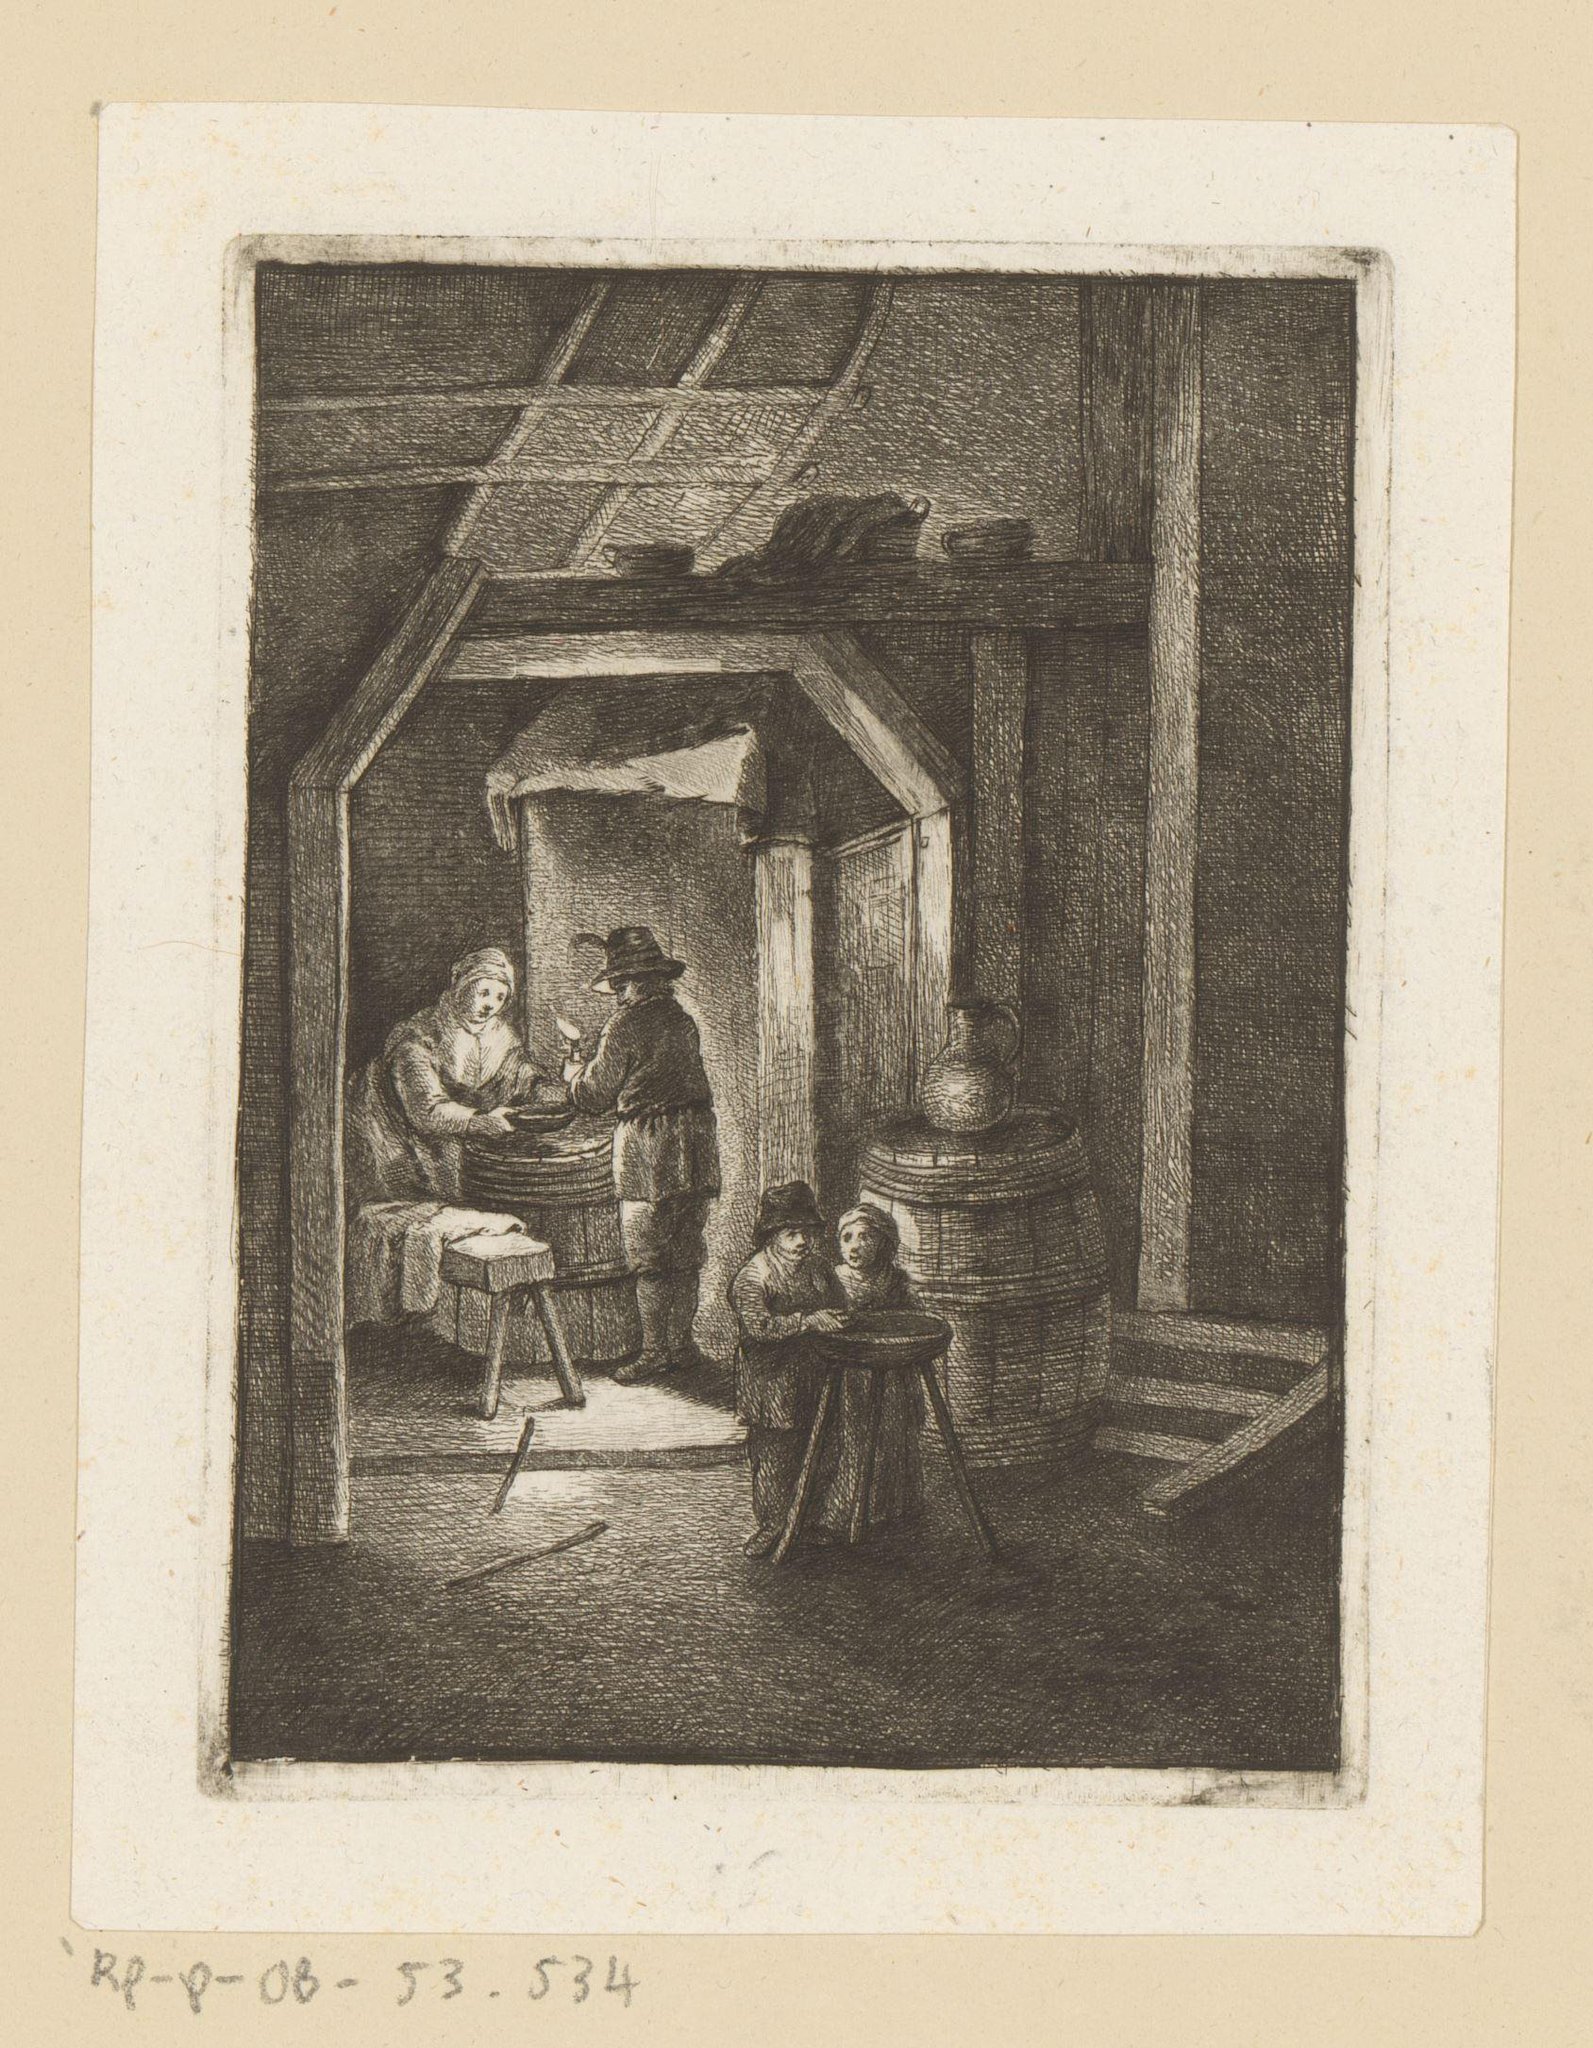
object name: print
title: Boeren interieur met man, vrouw en kinderen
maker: johann andreas benjamin nothnagel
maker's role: print maker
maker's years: 1729-1804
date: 1739-1804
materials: paper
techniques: etching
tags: farmers, interior of the house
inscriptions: collector's mark: Lugt 240